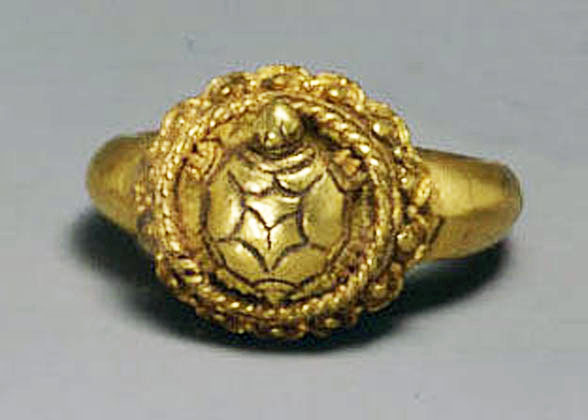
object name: ring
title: Ring with Tortoise Motif on Circular Bezel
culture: indonesian, javanese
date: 701-933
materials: gold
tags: animals